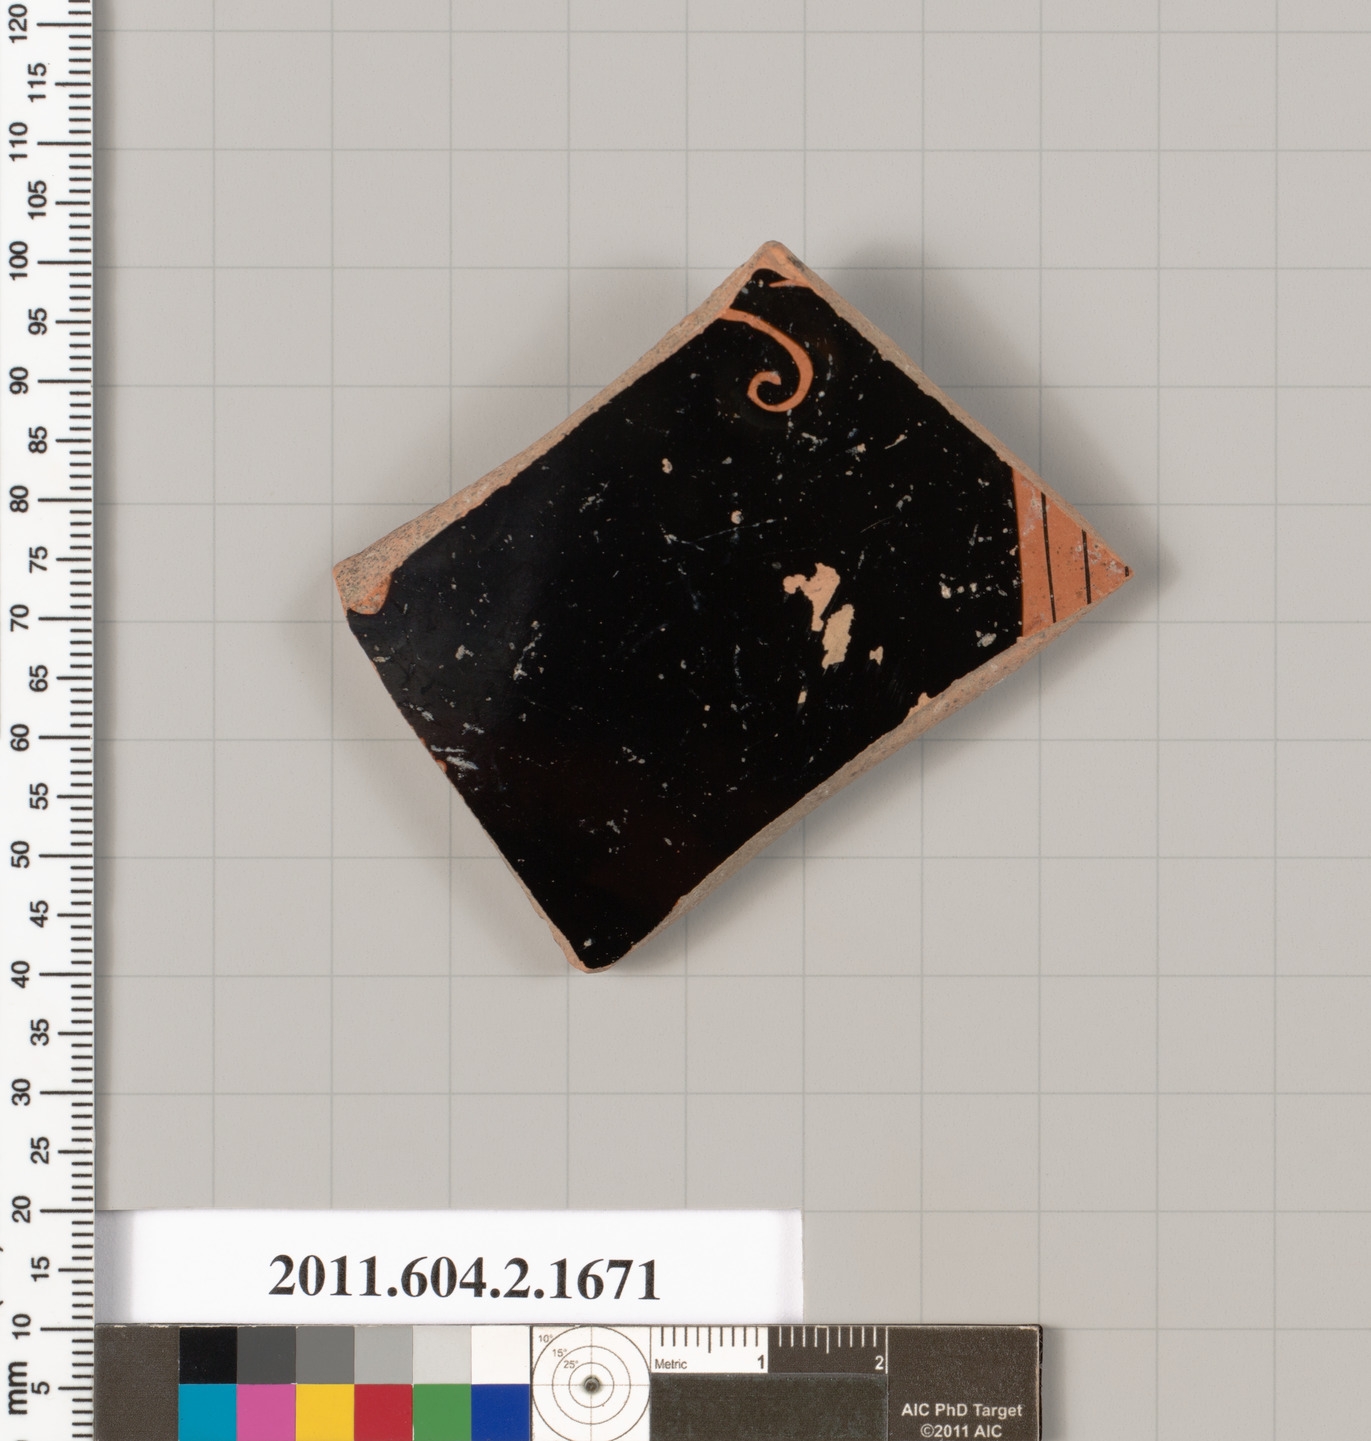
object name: skyphos fragment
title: Terracotta fragment of a skyphos (deep drinking cup)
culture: greek, attic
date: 460-440 BCE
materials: terracotta